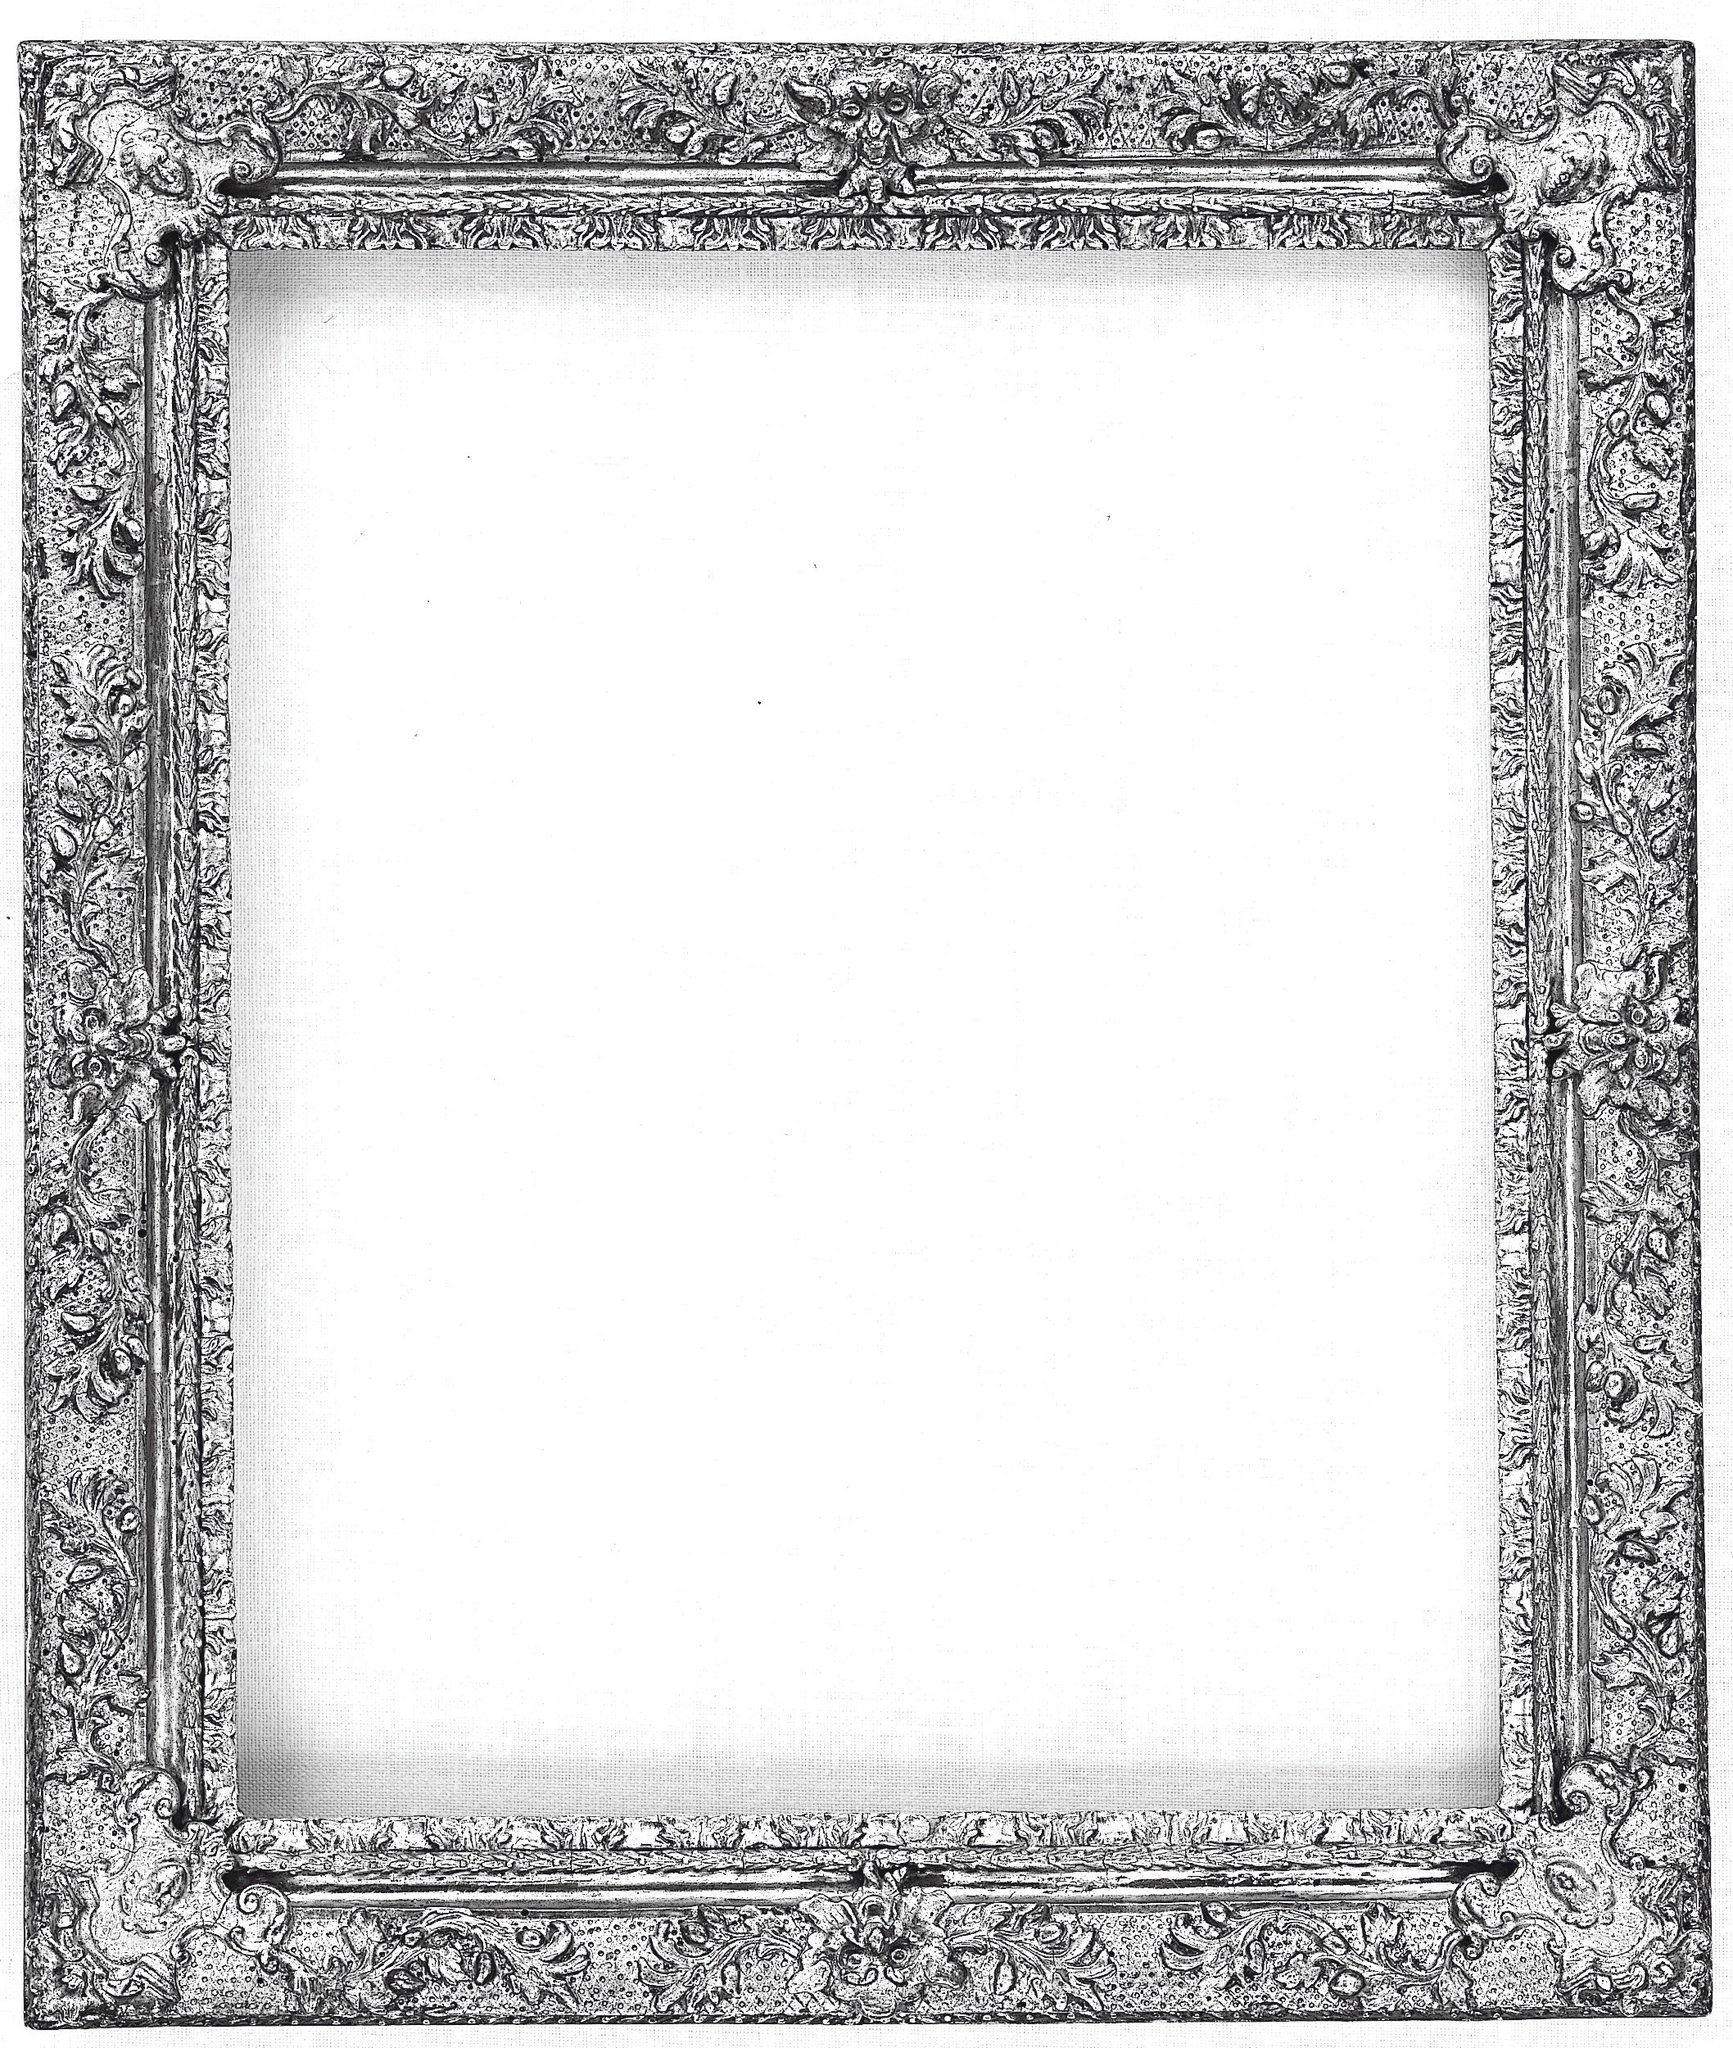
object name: frame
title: Louis XIV-style frame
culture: italian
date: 1772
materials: wood